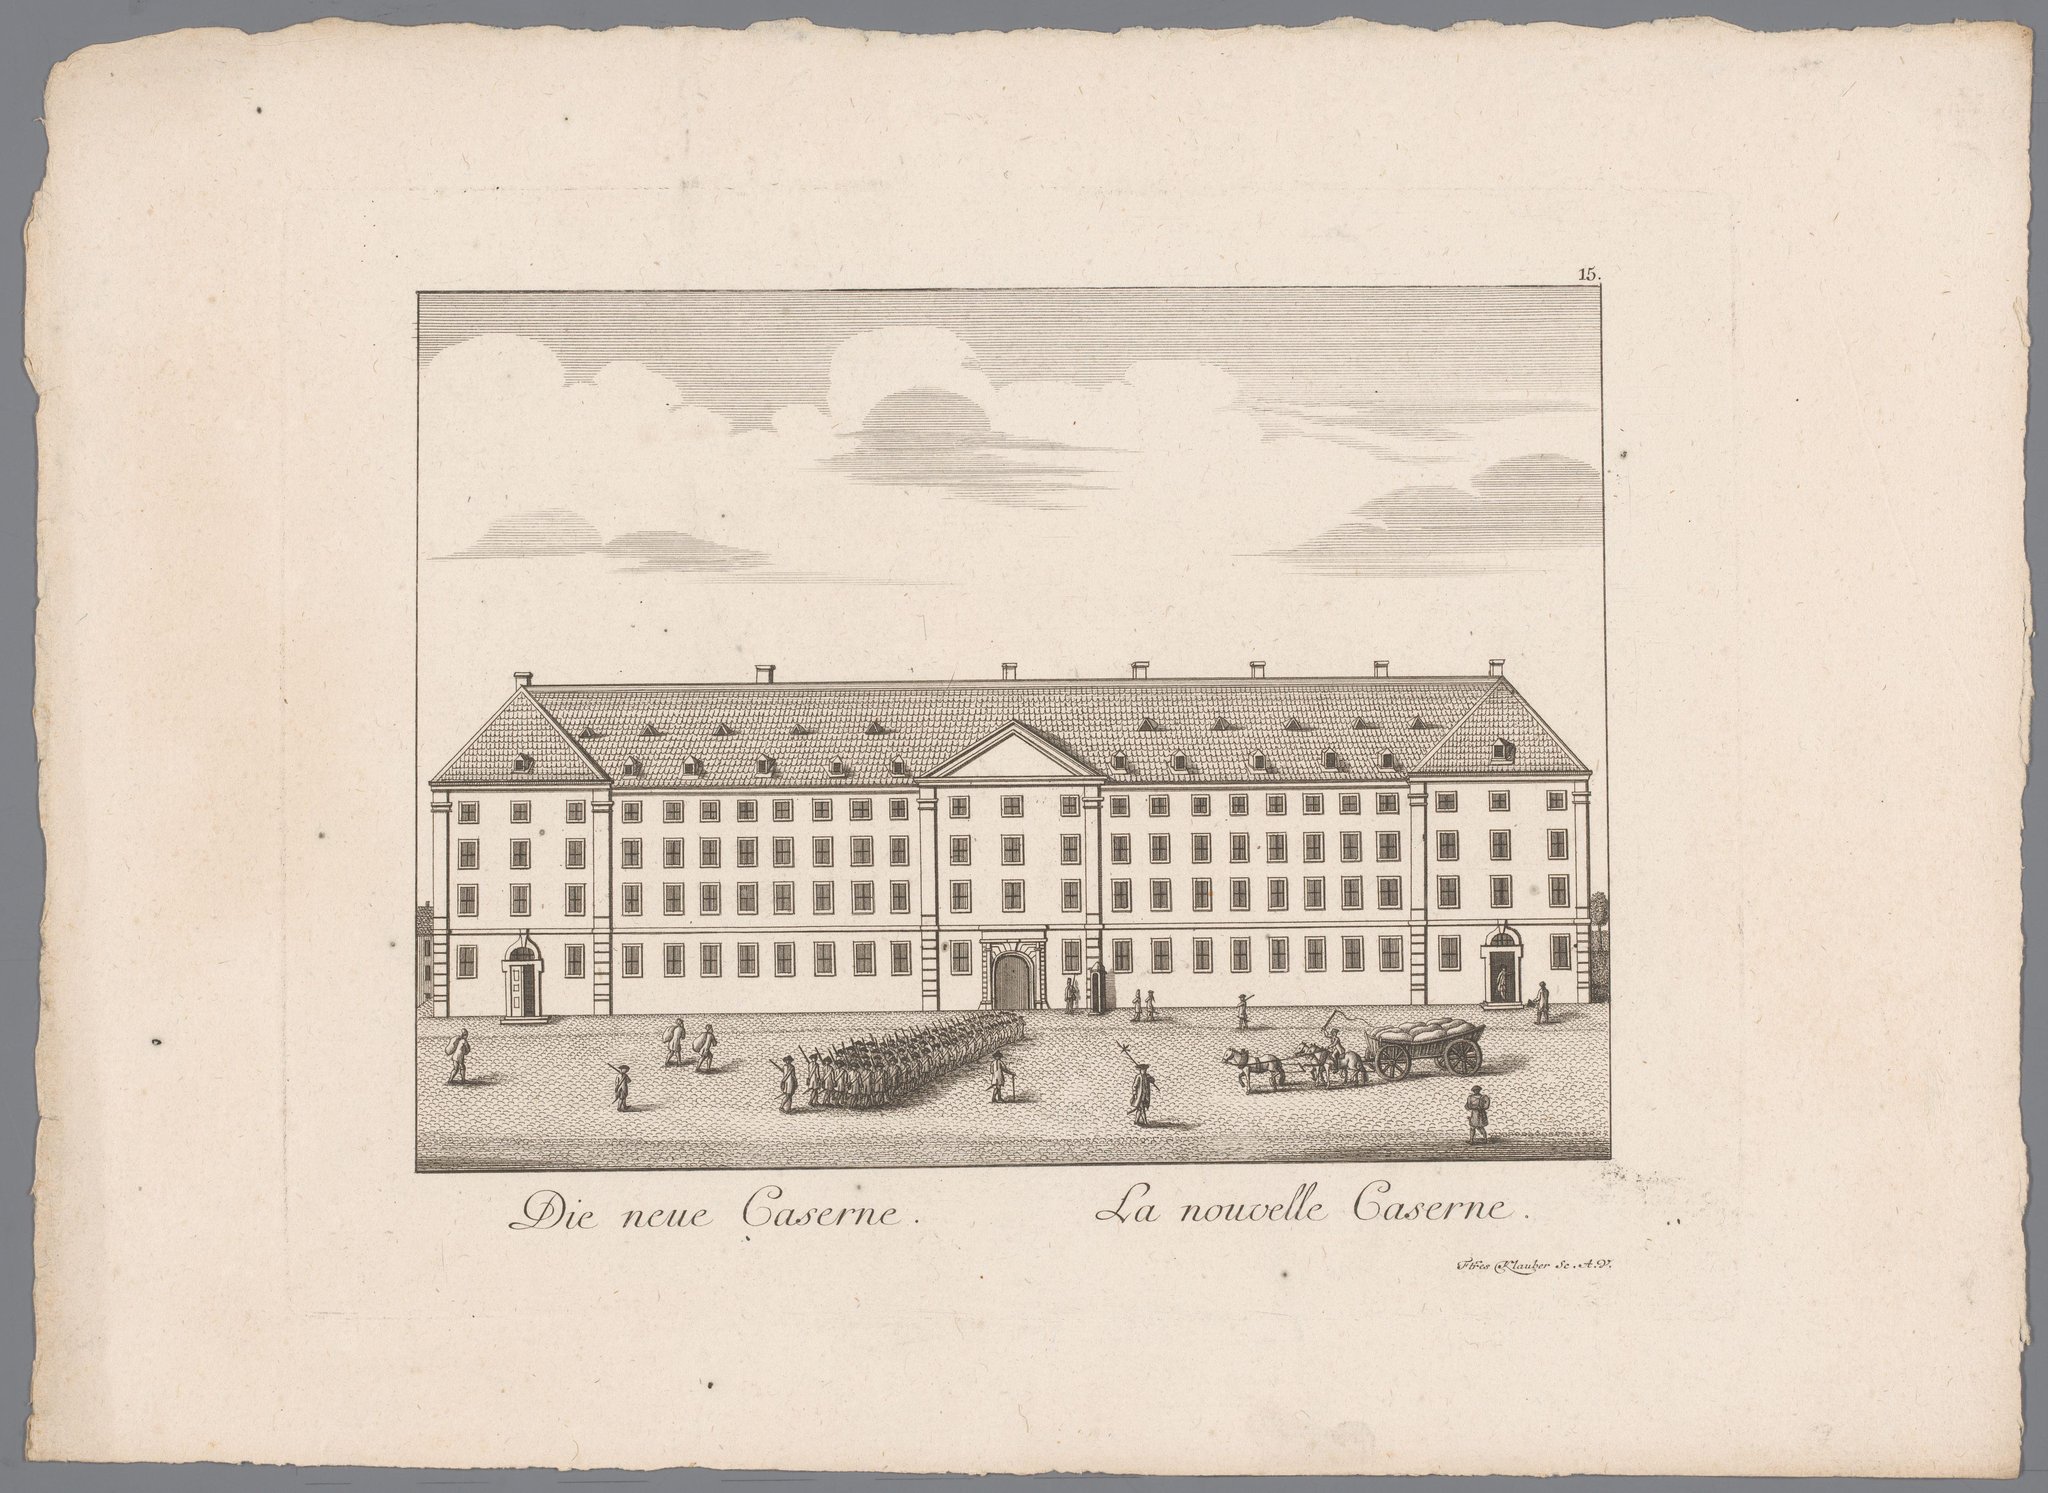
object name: print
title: Die neue Caserne / La nouvelle caserne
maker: christian friedrich schwan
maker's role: bookseller, publisher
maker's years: 1733-1815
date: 1782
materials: paper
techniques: etching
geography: augsburg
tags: barracks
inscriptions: collector's mark: Lugt 2228